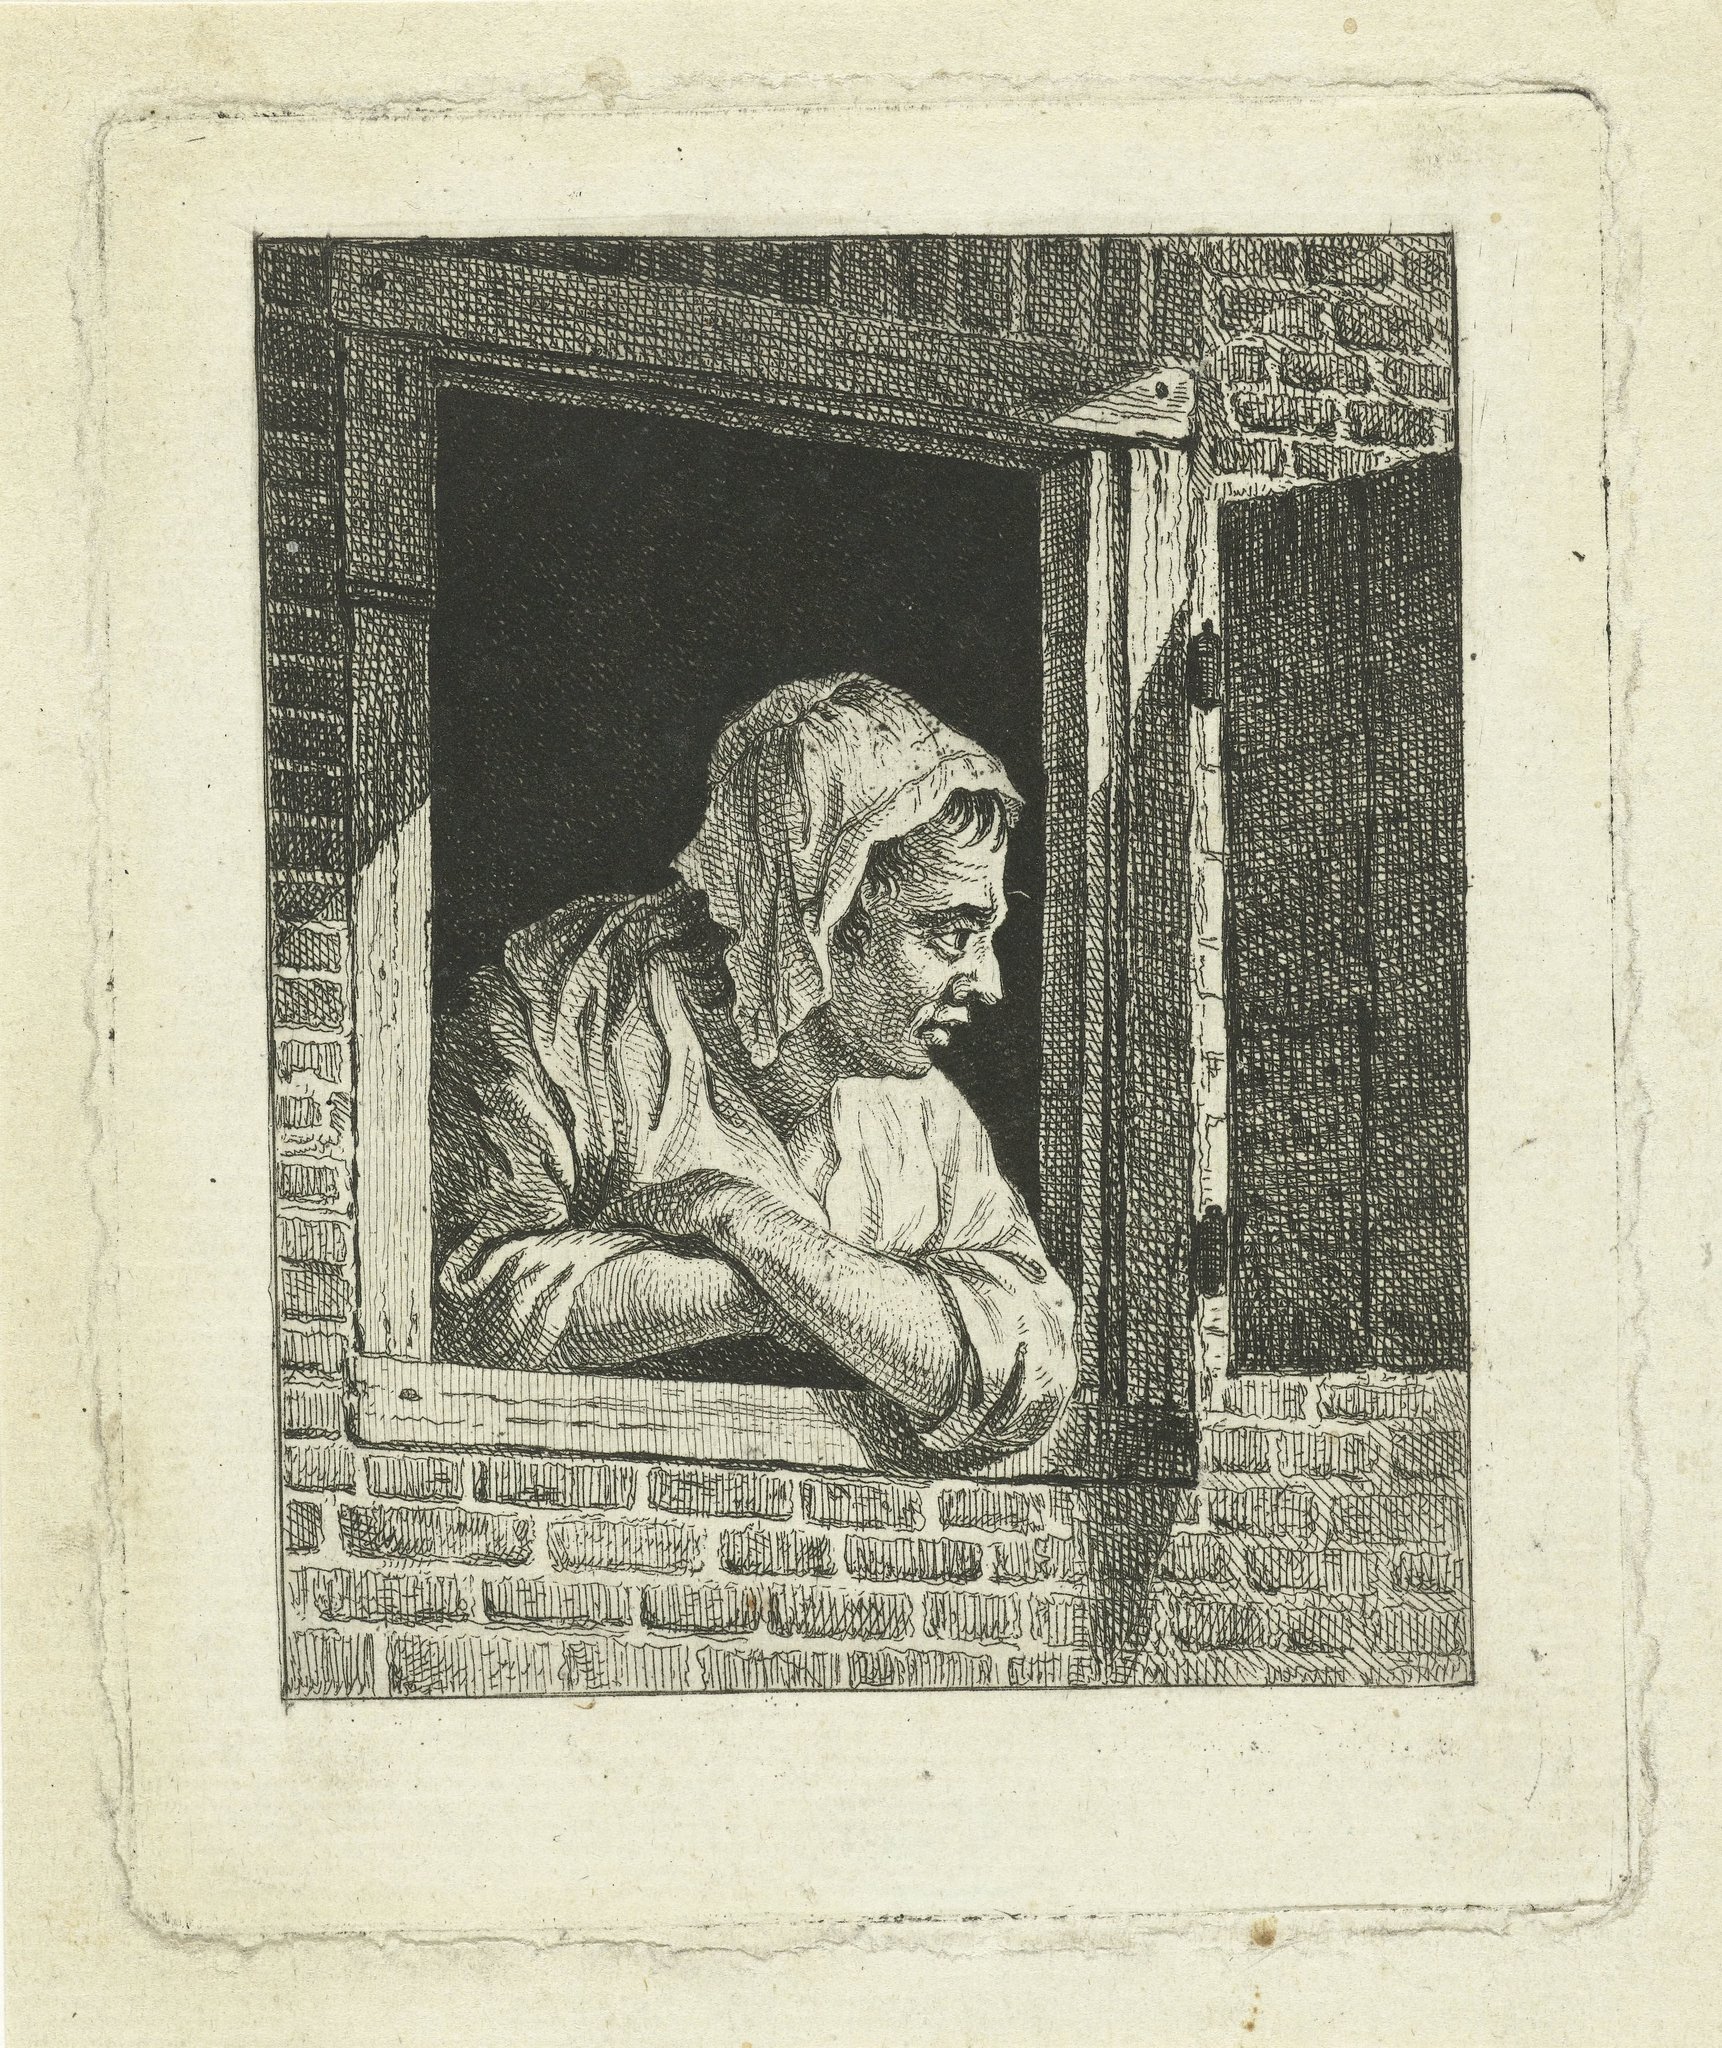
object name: print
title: Vrouw leunend op armen in raamopening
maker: cornelis van cuijlenburgh (ii)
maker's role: painter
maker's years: 1758-1827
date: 1768-1827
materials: paper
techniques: etching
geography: netherlands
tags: human figure at (open) window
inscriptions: collector's mark: Lugt 2228